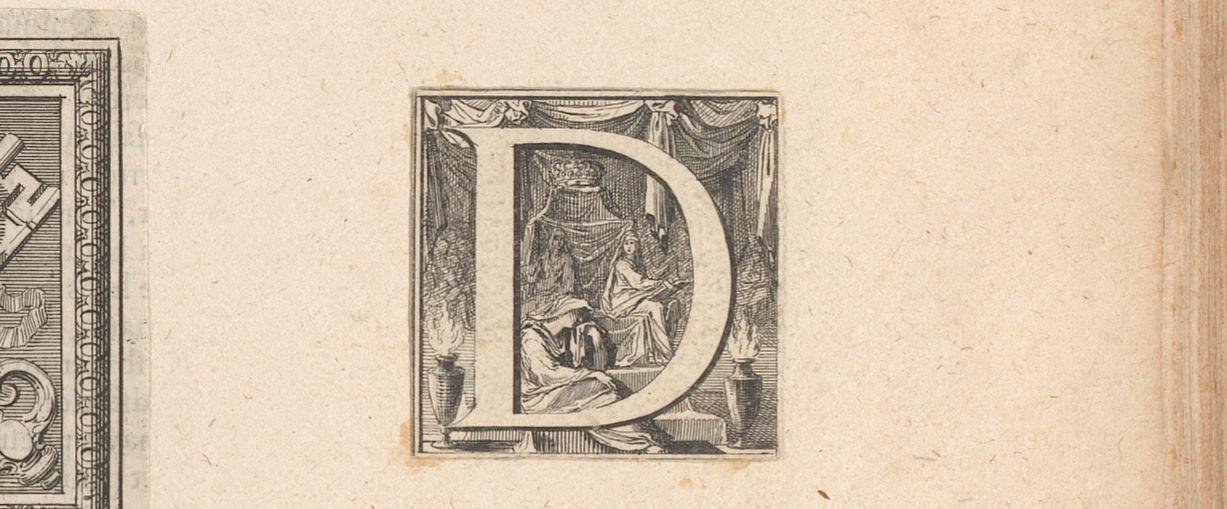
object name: album leaf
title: Initiaal 'D' met gezicht op een grafmonument of mausoleum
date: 1684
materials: paper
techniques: etching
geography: paris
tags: initial, mausoleum, grave-building, monumental tomb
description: Initiaal gebruikt voor: Cureau de La Chambre, Abbé Pierre. Oraison funebre de Marie Terese d'Austriche (...). Parijs: Gabriel Martin, 1684.